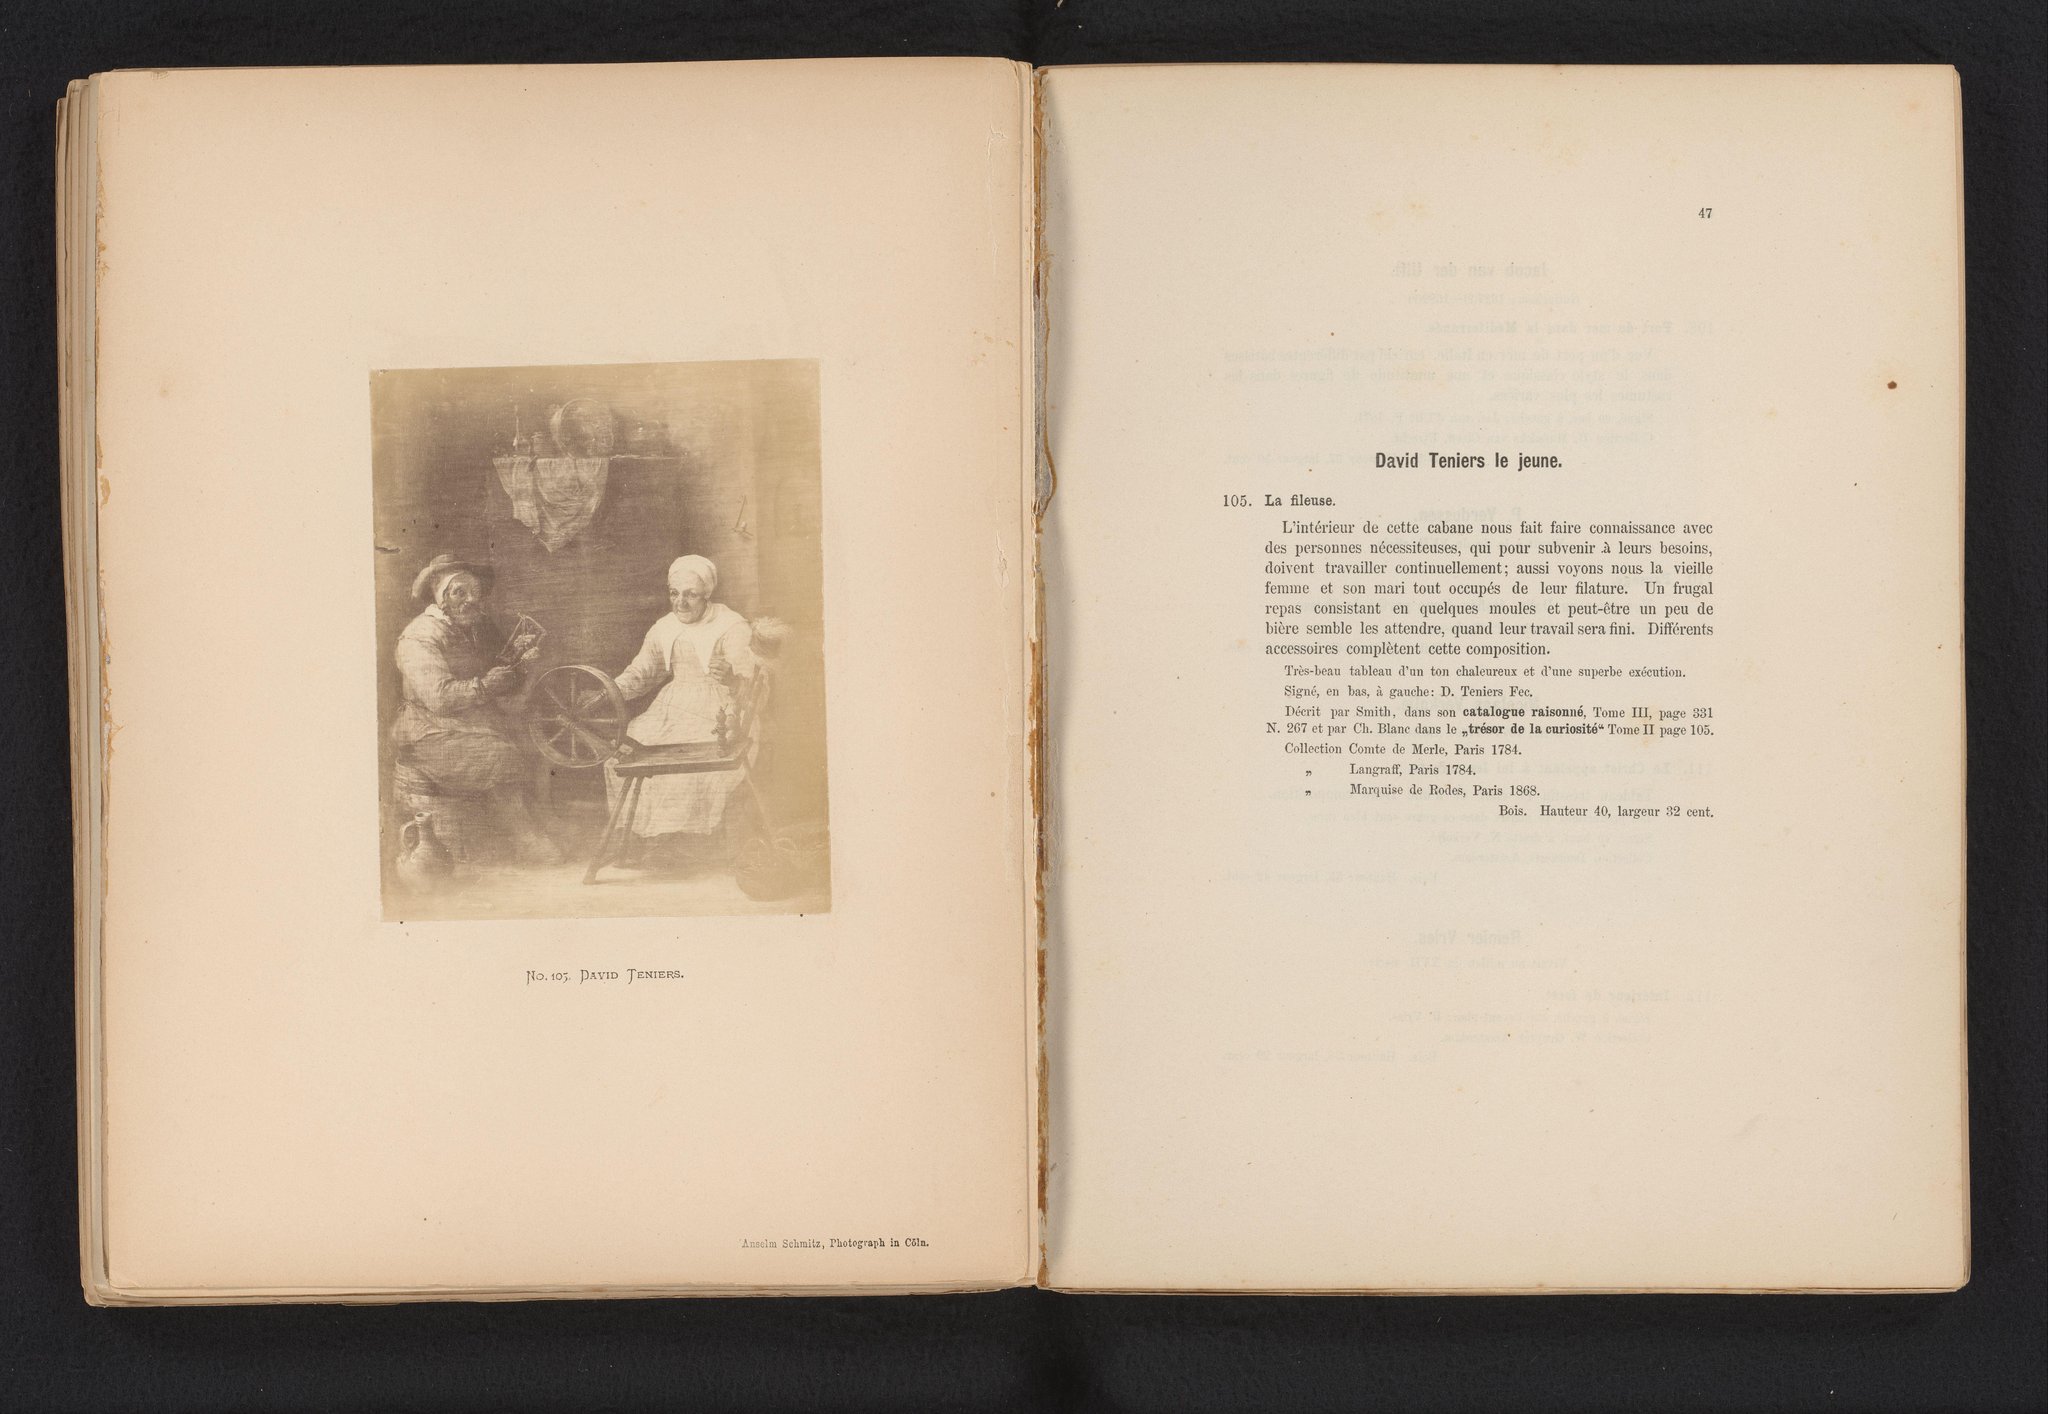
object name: reproduction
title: Fotoreproductie van een schilderij van een man en vrouw aan het spinnewiel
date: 1871-1876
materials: photographic support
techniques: albumen print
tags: spinning-wheel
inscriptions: inscription: ‘No. 105. David Teniers’